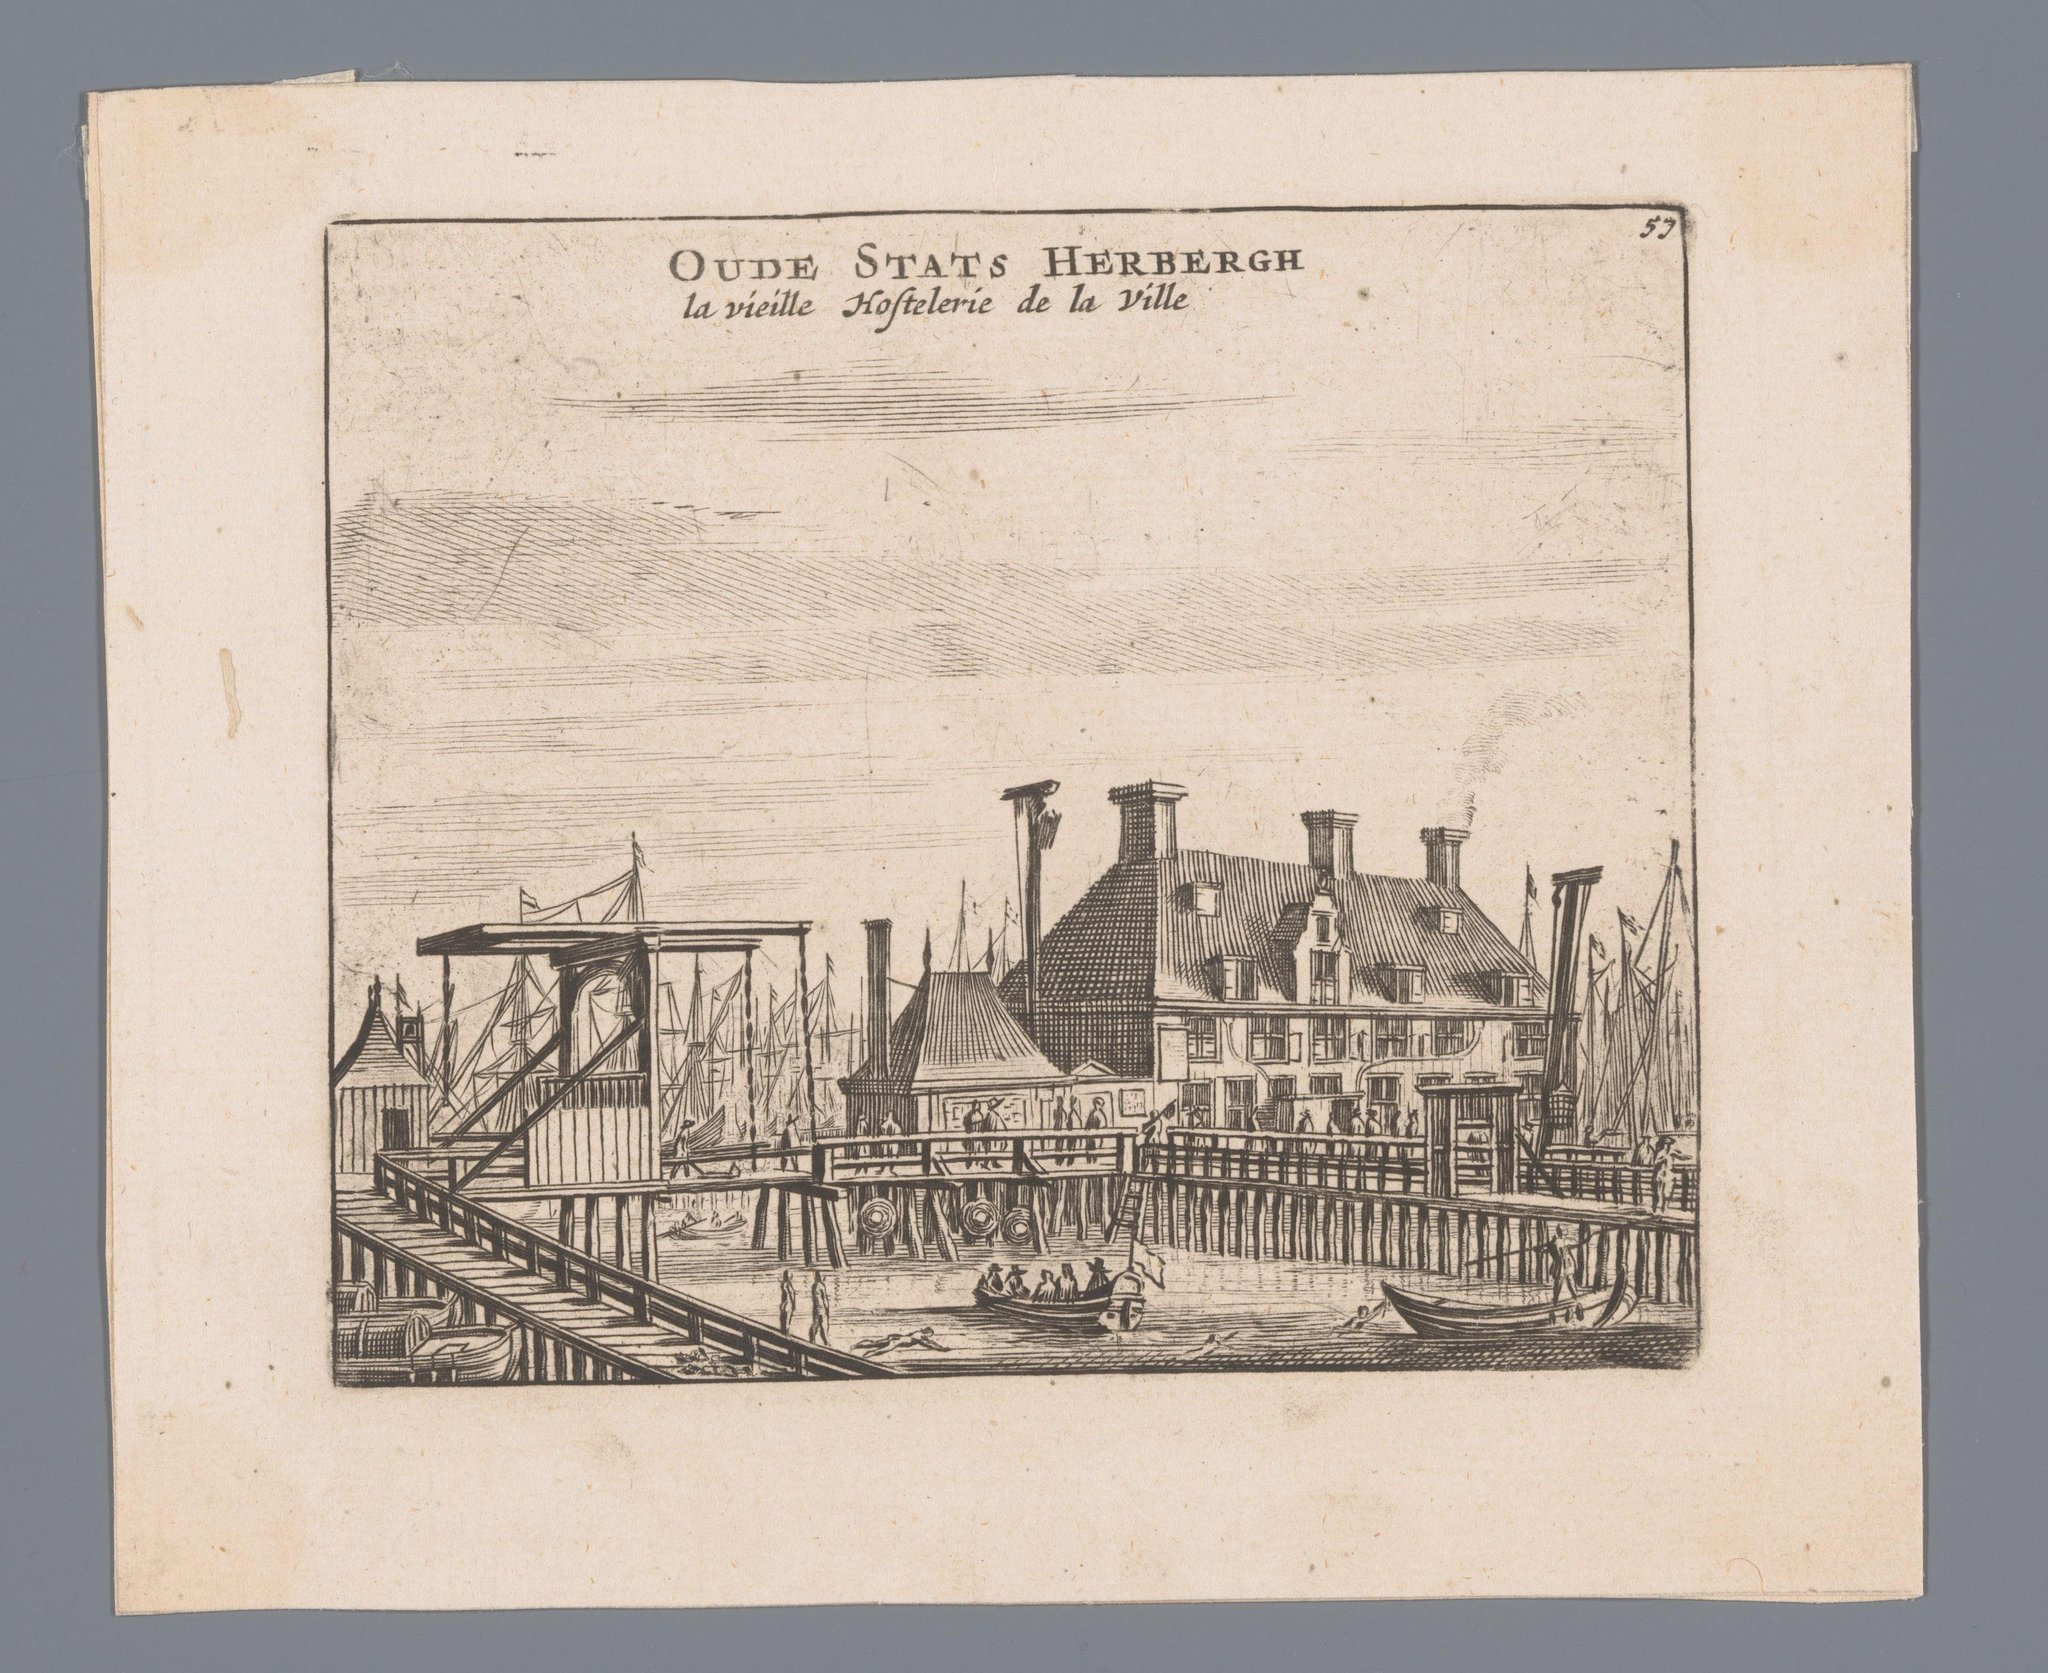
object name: print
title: Oude Stats Herbergh / La vieille Hostelerie de la ville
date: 1665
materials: paper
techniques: etching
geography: amsterdam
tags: rowing-boat, canoe, etc., bridge in city across river, canal, etc., hotel, hostelry, inn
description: Prent uit: Domselaer, Tobias van. Beschryvinge van Amsterdam : haar eerste oorspronk uyt den huyze der heeren van Aemstel en Aemstellant (...). Amsterdam: Marcus Willemsz. Doornick, 1665, p. 221.